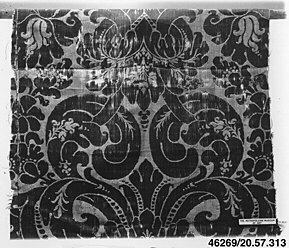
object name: piece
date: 1601-1700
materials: silk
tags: flowers